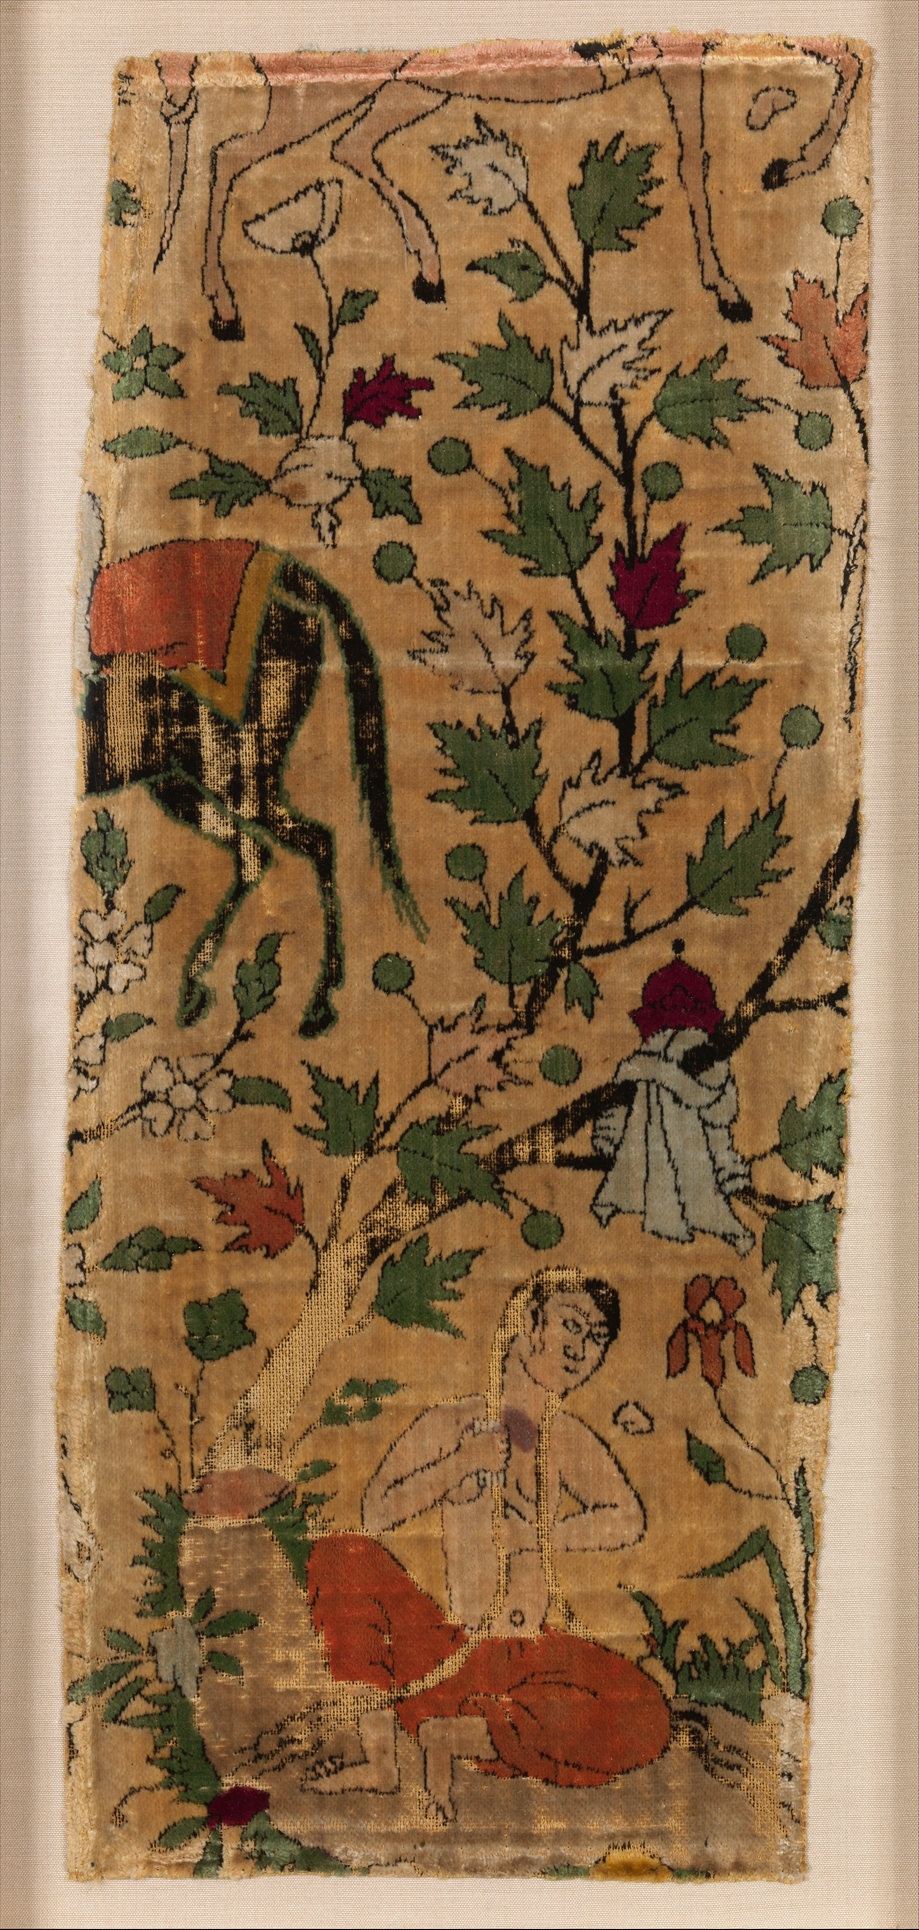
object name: fragment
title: Velvet Fragment with Design from Nizami of Ganja's Khusrau and Shirin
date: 1501-1600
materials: silk, velvet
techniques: cutting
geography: iran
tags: female nudes,horses,bathing